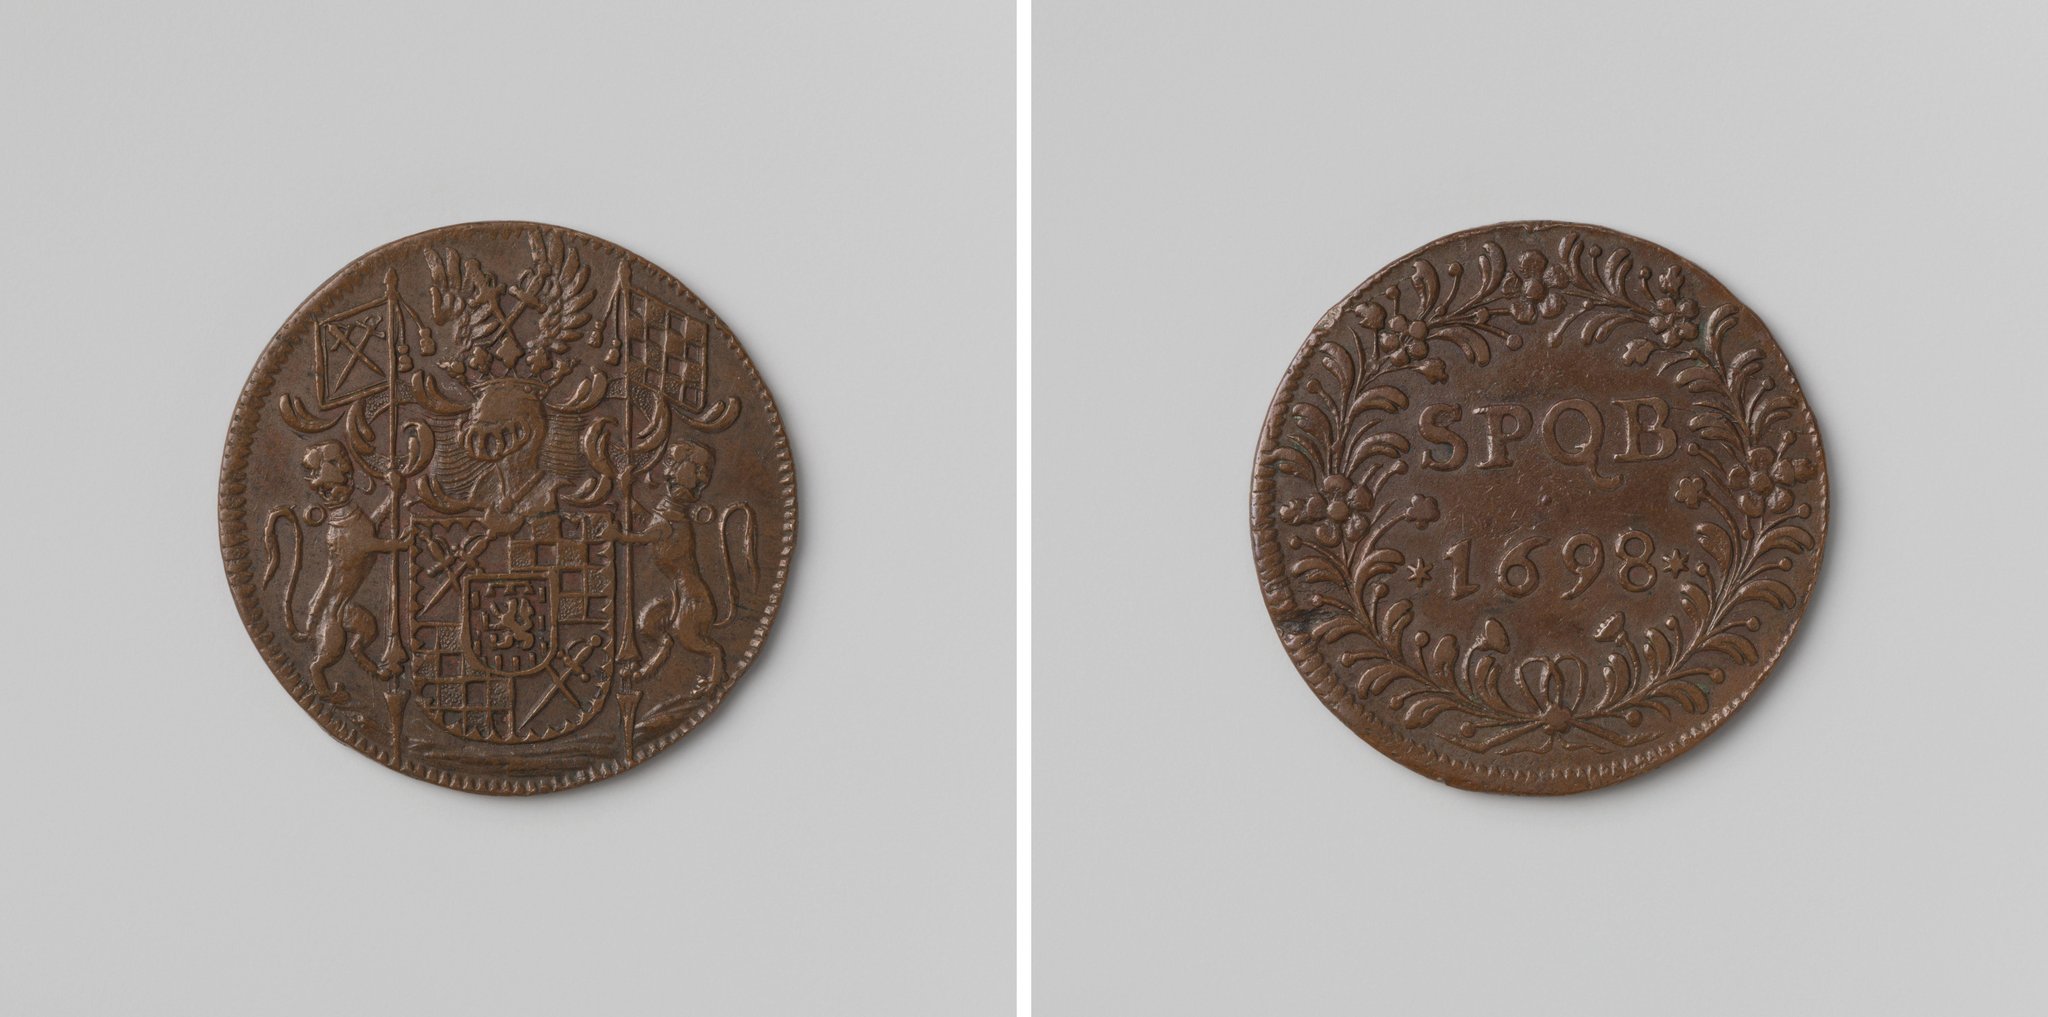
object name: jeton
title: Guillaume Francois de Paffenrode, magistraat van de schatkist van Brussel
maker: Anonymous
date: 1601-1698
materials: copper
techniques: striking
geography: brussels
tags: brussels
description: Koperen penning. Voorzijde: gehelmd wapenschild, geflankeerd door twee leeuwen met banieren. Keerzijde: opschrift binnen bloemenkrans